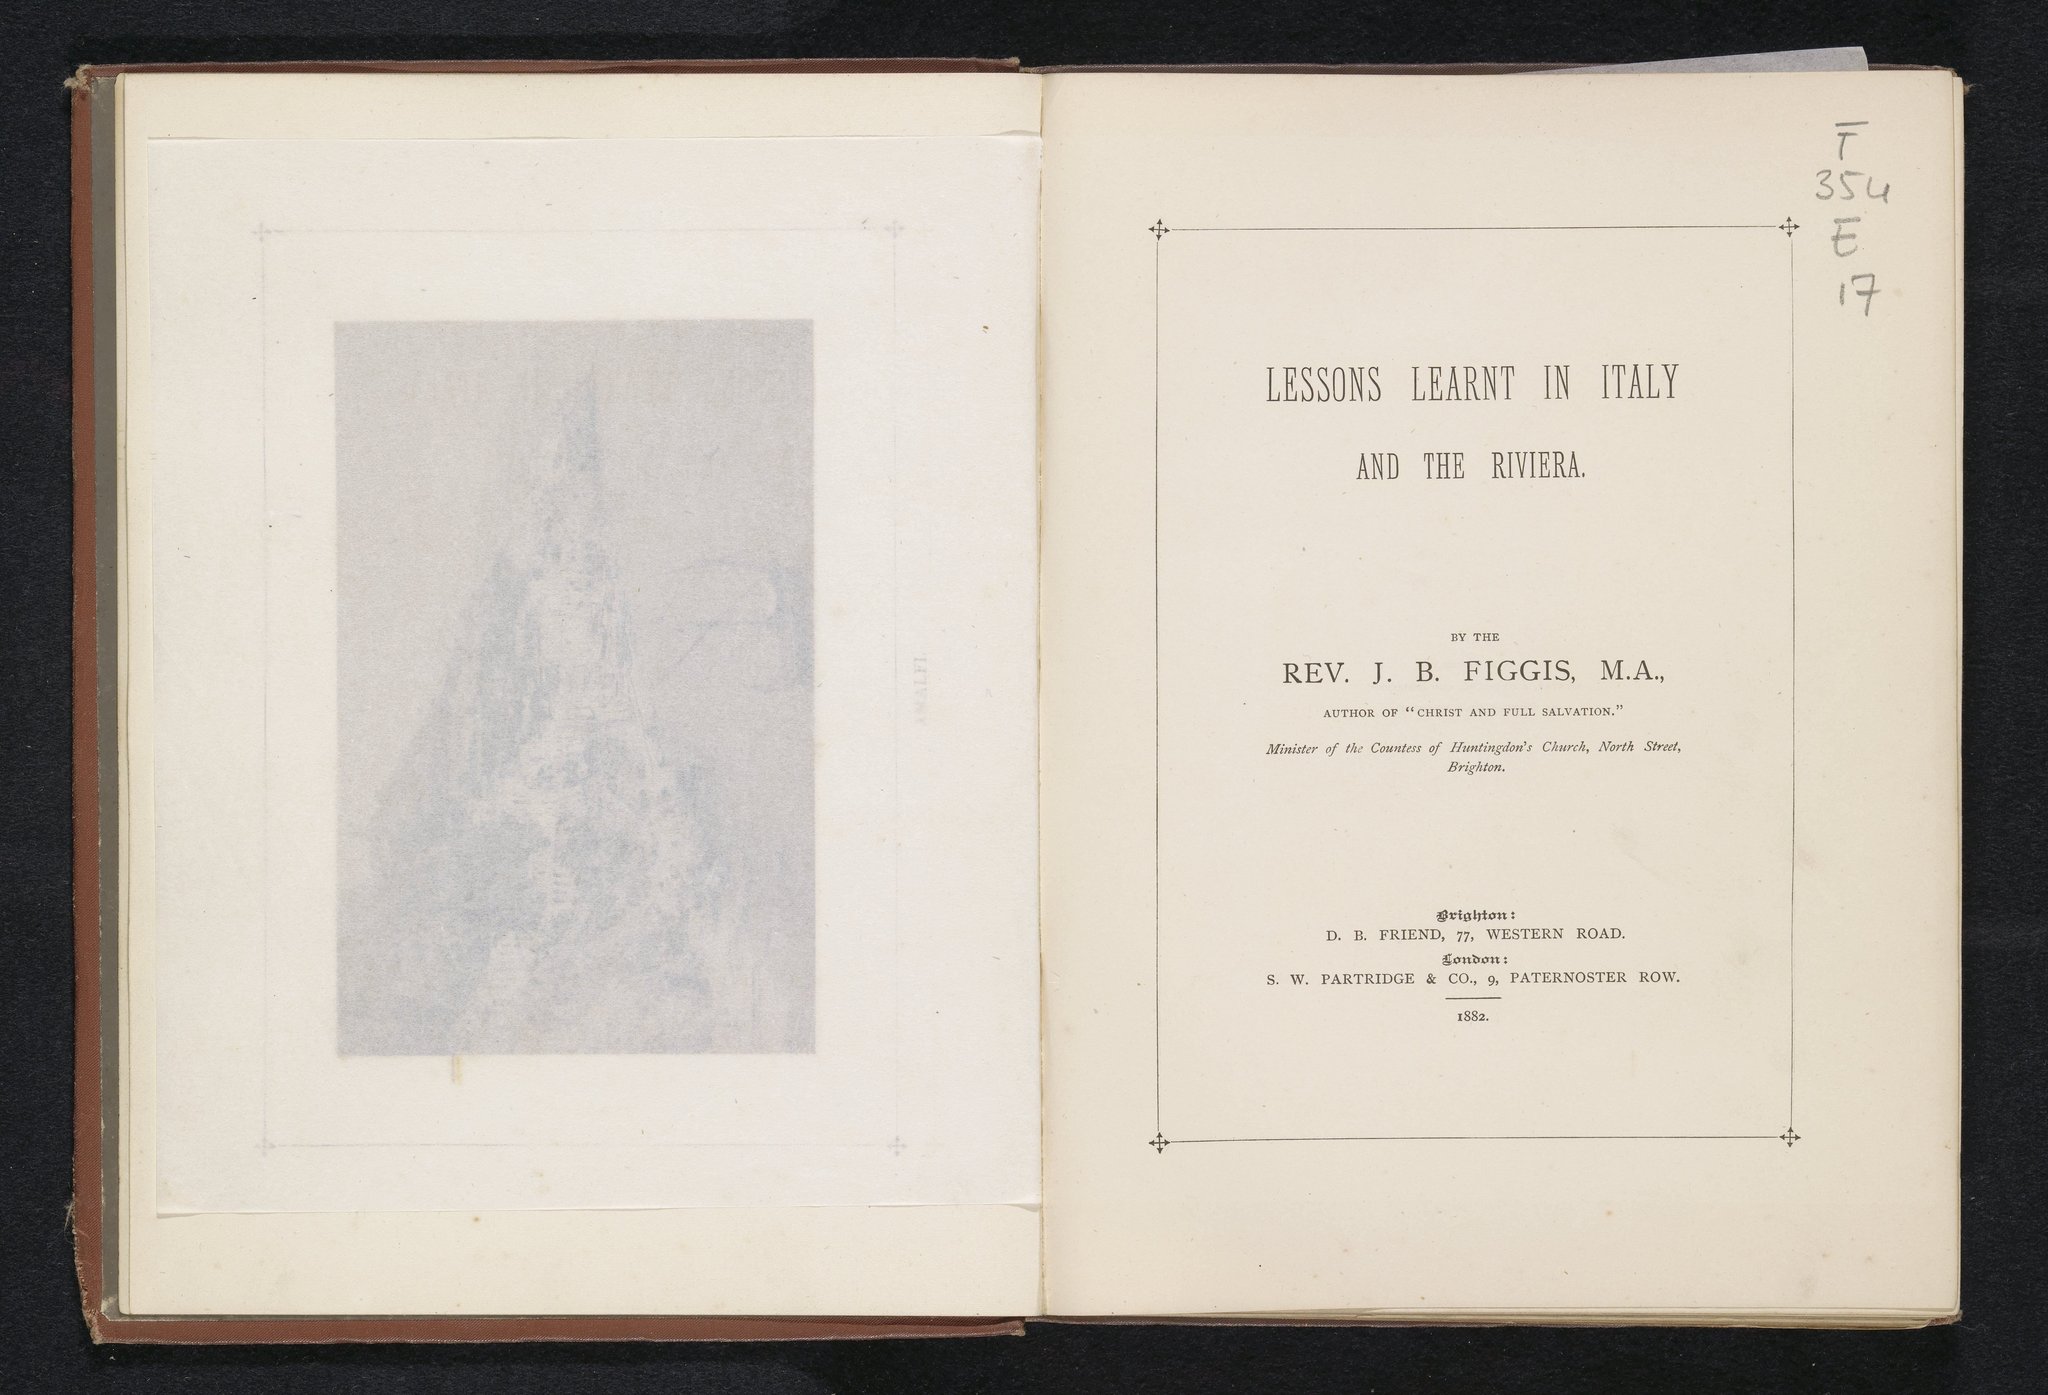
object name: book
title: Lessons learnt in Italy and the Riviera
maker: j.b. figgis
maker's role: auteur, dominee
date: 1882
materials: cardboard, linen, paper, photographic support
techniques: albumen print, printing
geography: london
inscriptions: inscription: ‘Wish all good wisjes and Kind regards to Rev [...] Rowland Stuart on the occasion of their marriage ! from D. D. Burchell [...] September, 1902’